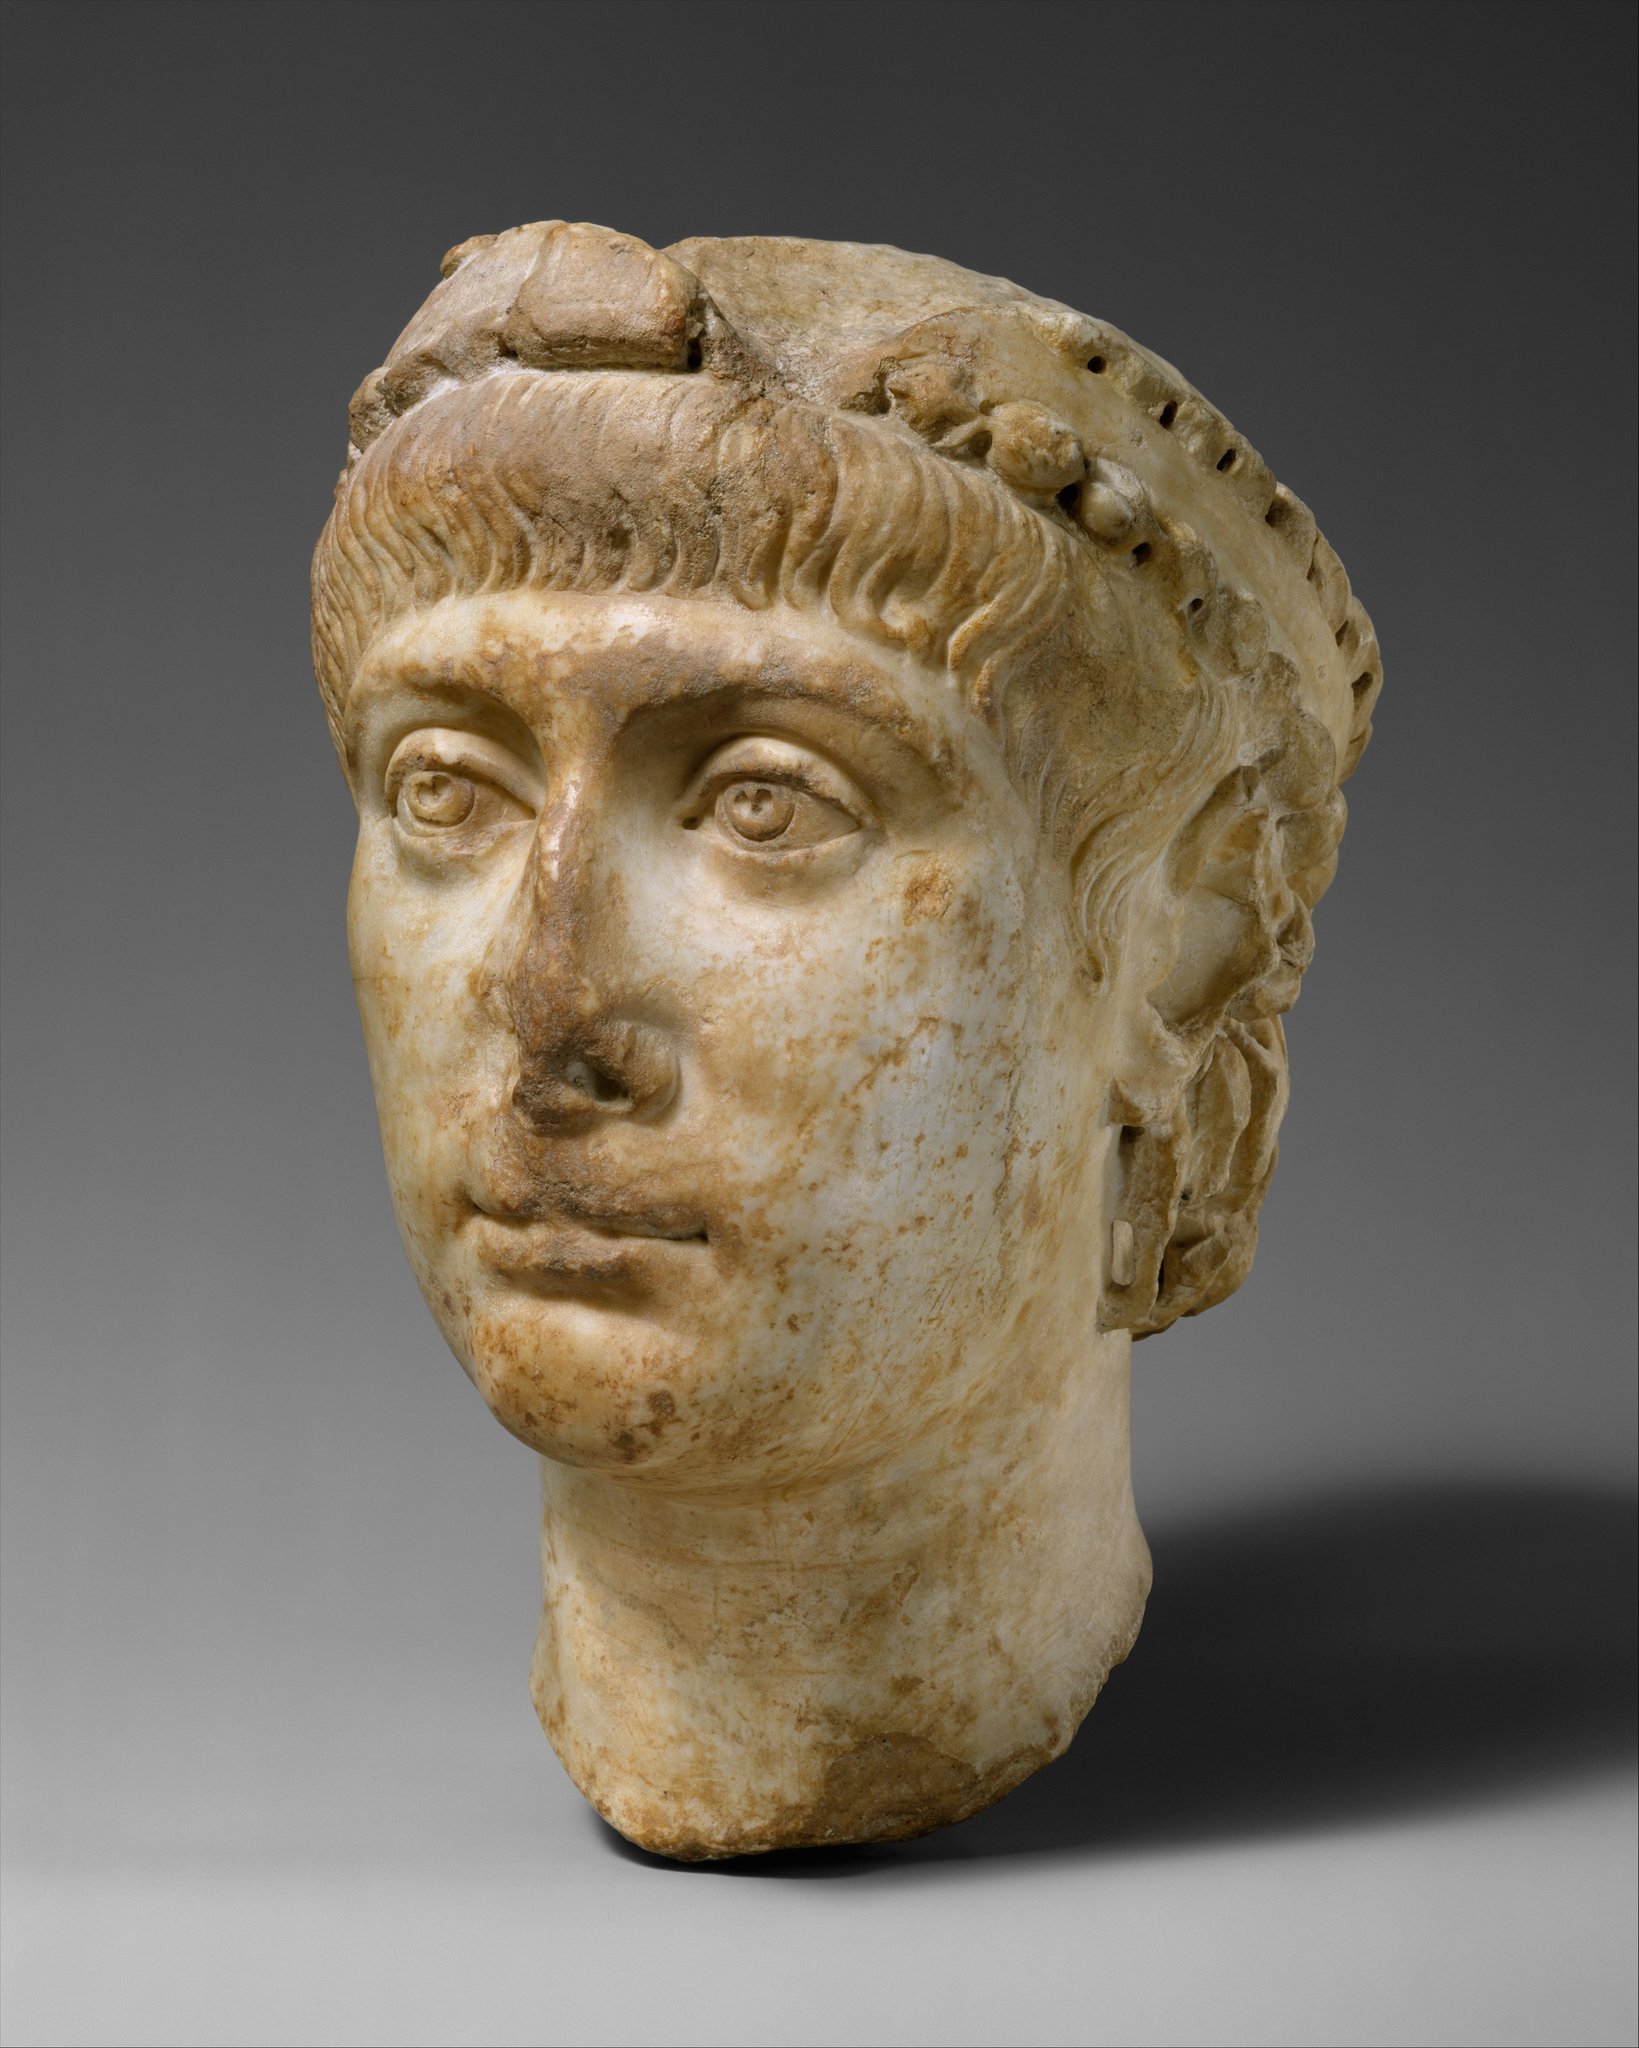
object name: statue head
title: Head of Emperor Constans (r. 337–50)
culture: byzantine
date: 337-340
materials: marble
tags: emperors,men